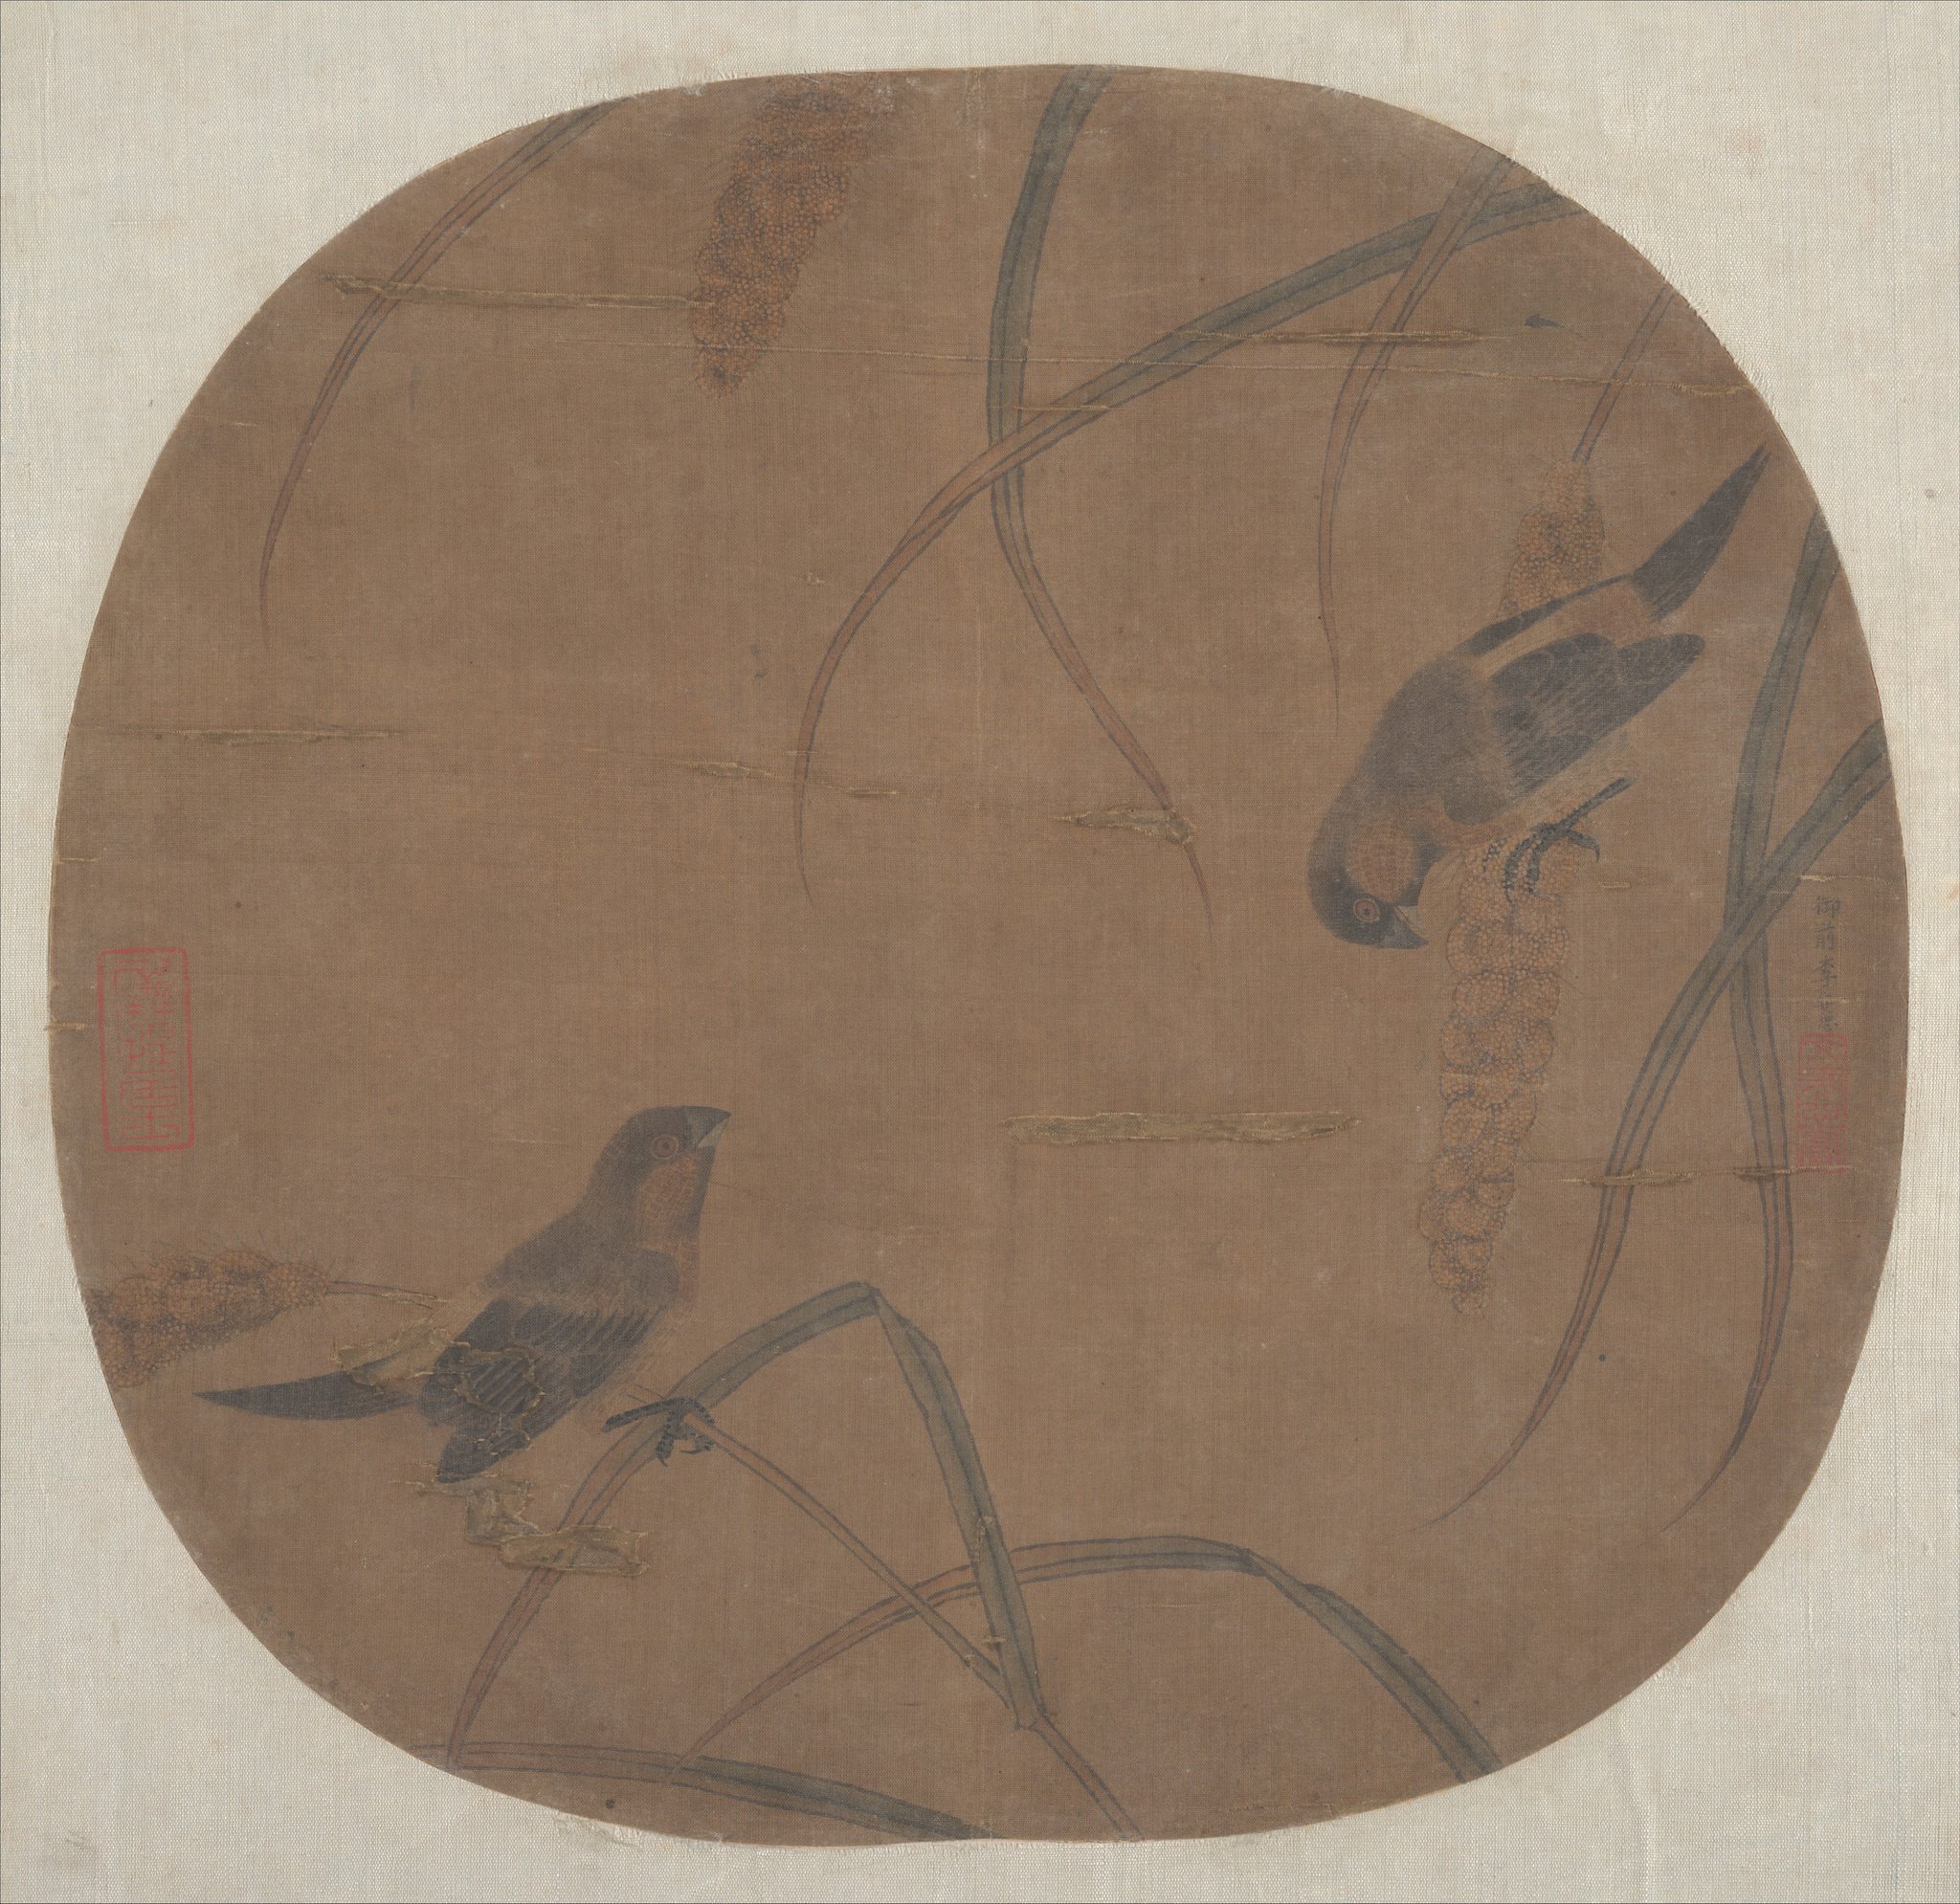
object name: fan mounted a an album leaf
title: Sparrows and Millet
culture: chinese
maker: unidentified artist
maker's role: artist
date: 1368-1644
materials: ink, silk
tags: birds